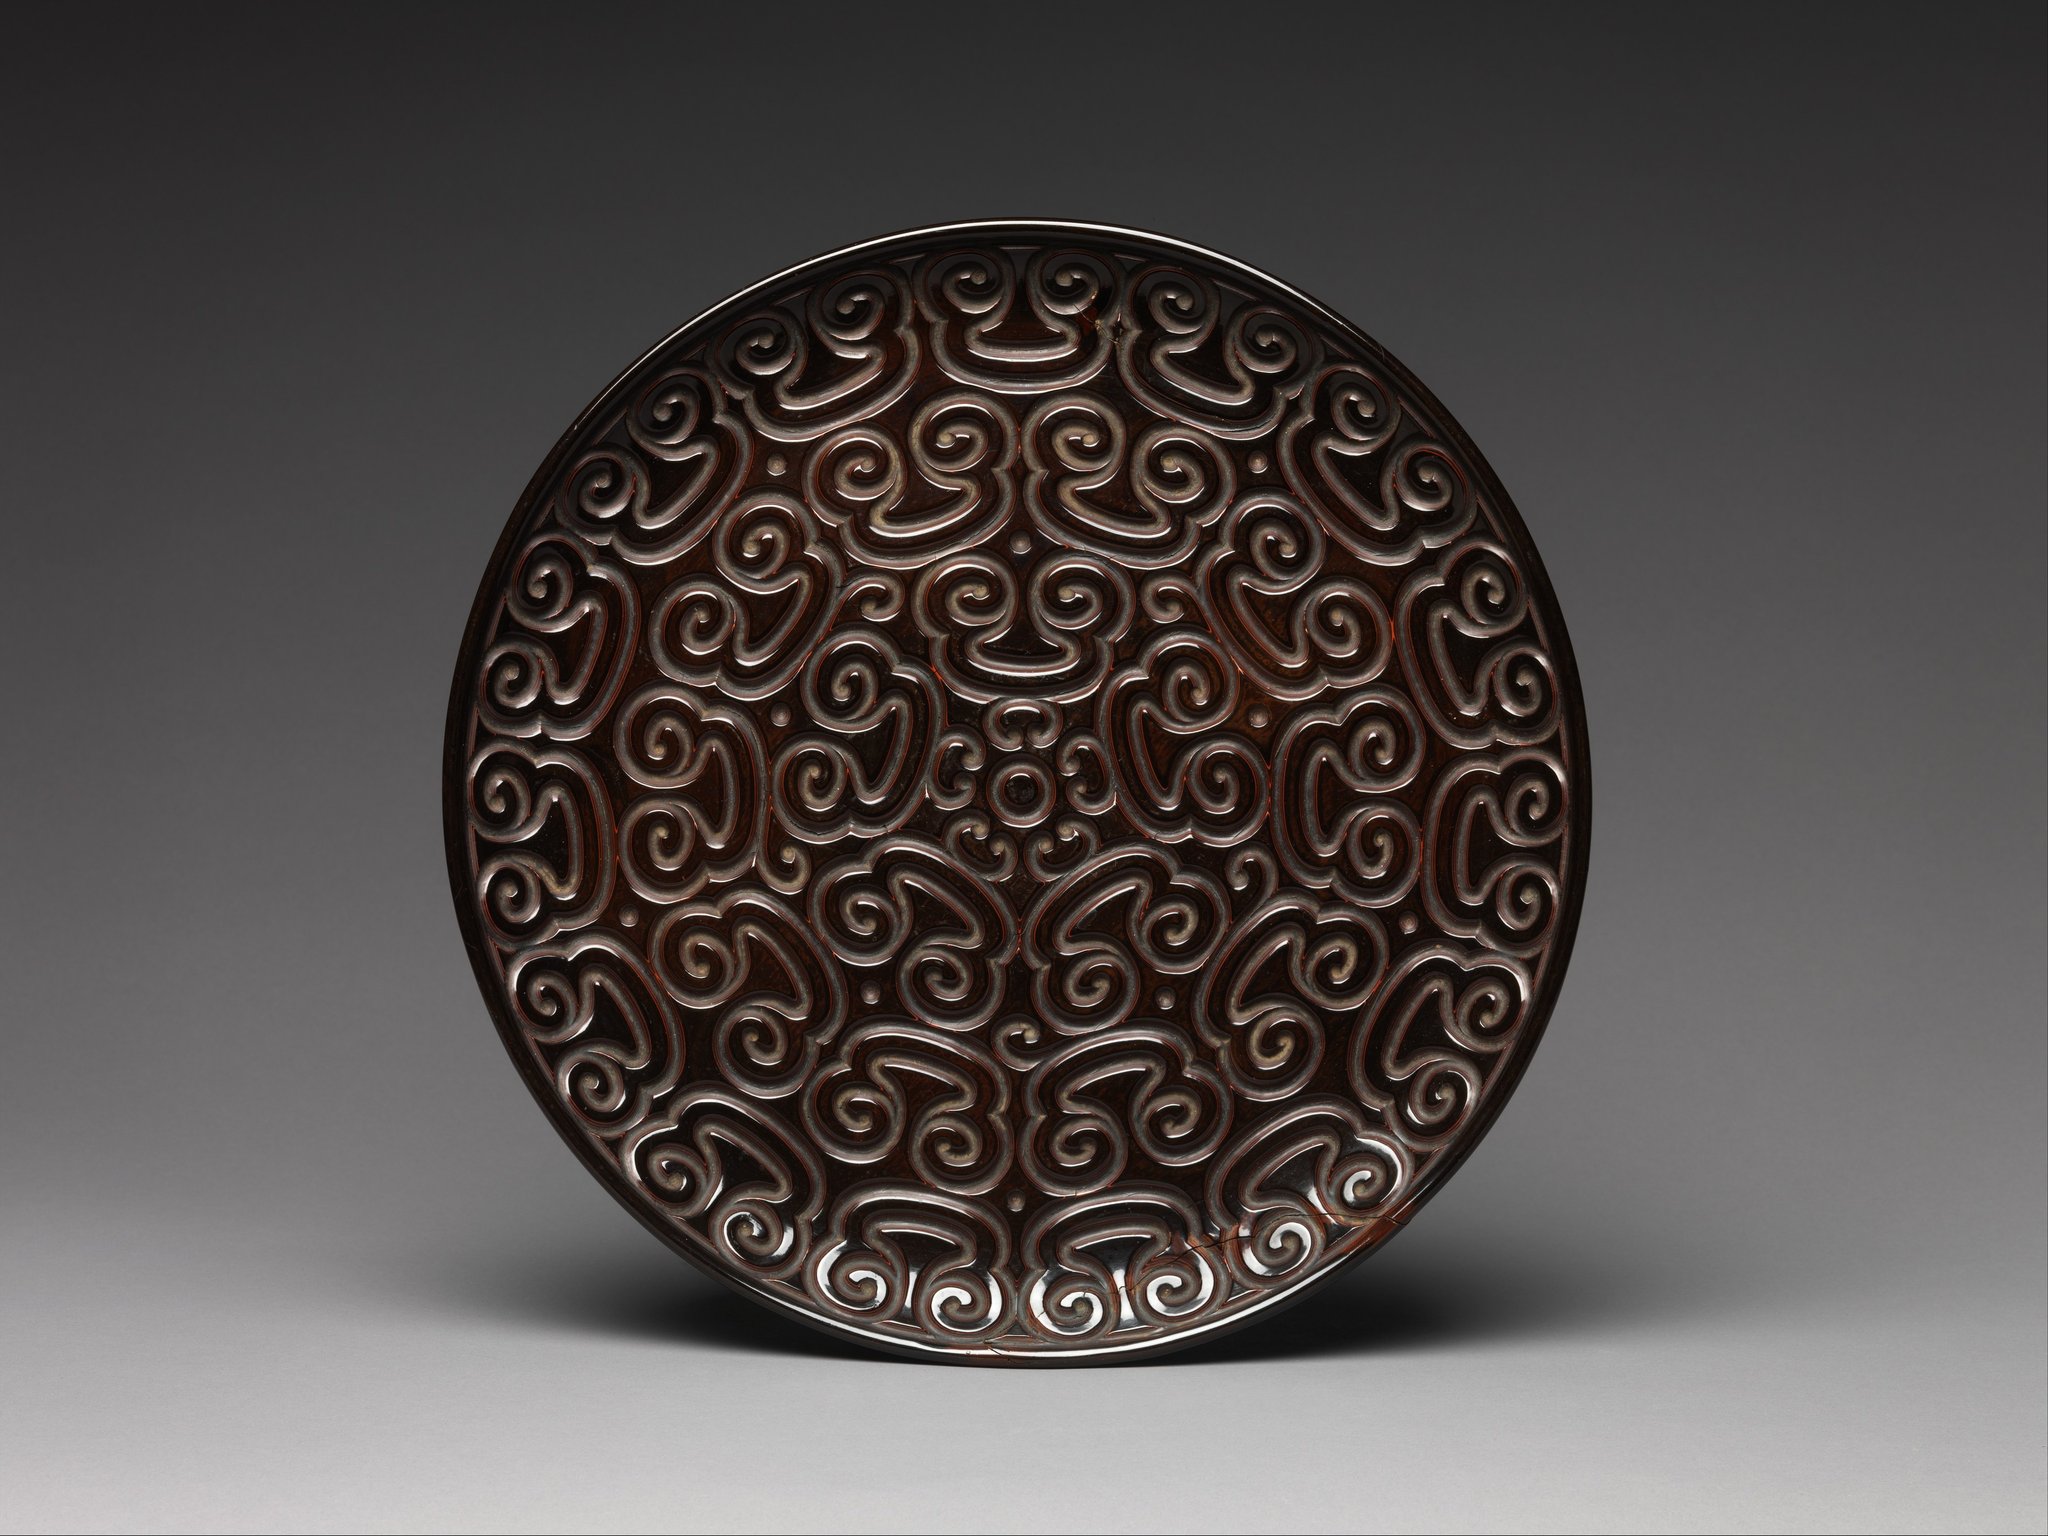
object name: dish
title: Dish with Pommel Scroll Design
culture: chinese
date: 1301-1400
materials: lacquer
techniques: carving